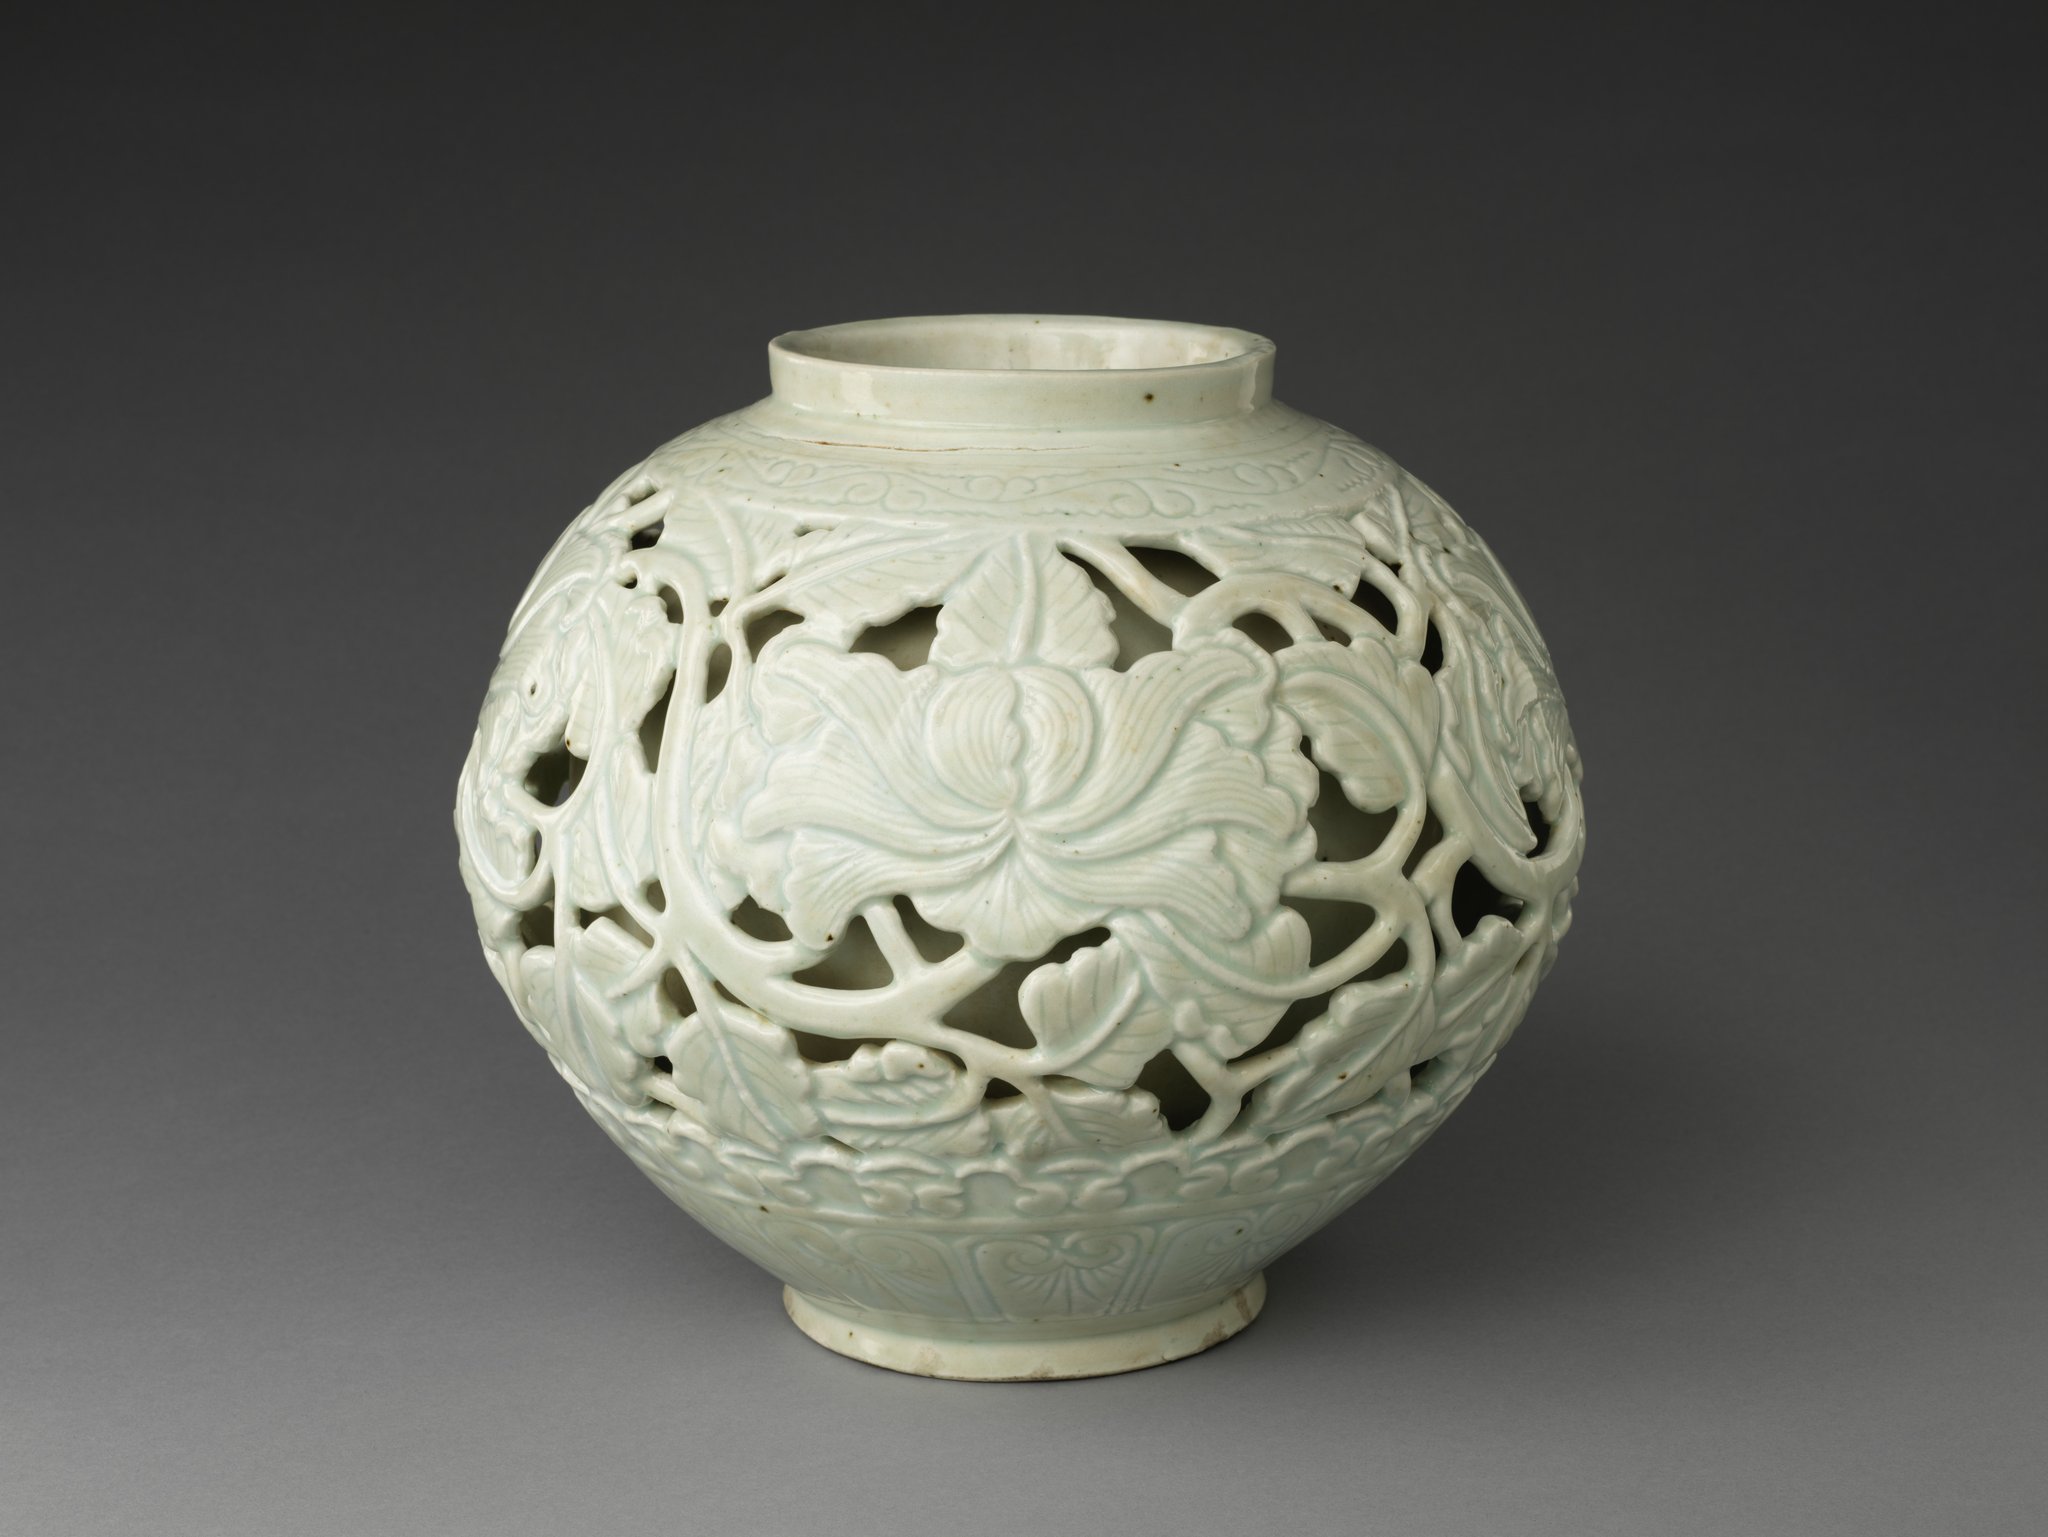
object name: jar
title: Openwork jar with peonies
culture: korean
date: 1767-1833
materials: porcelain